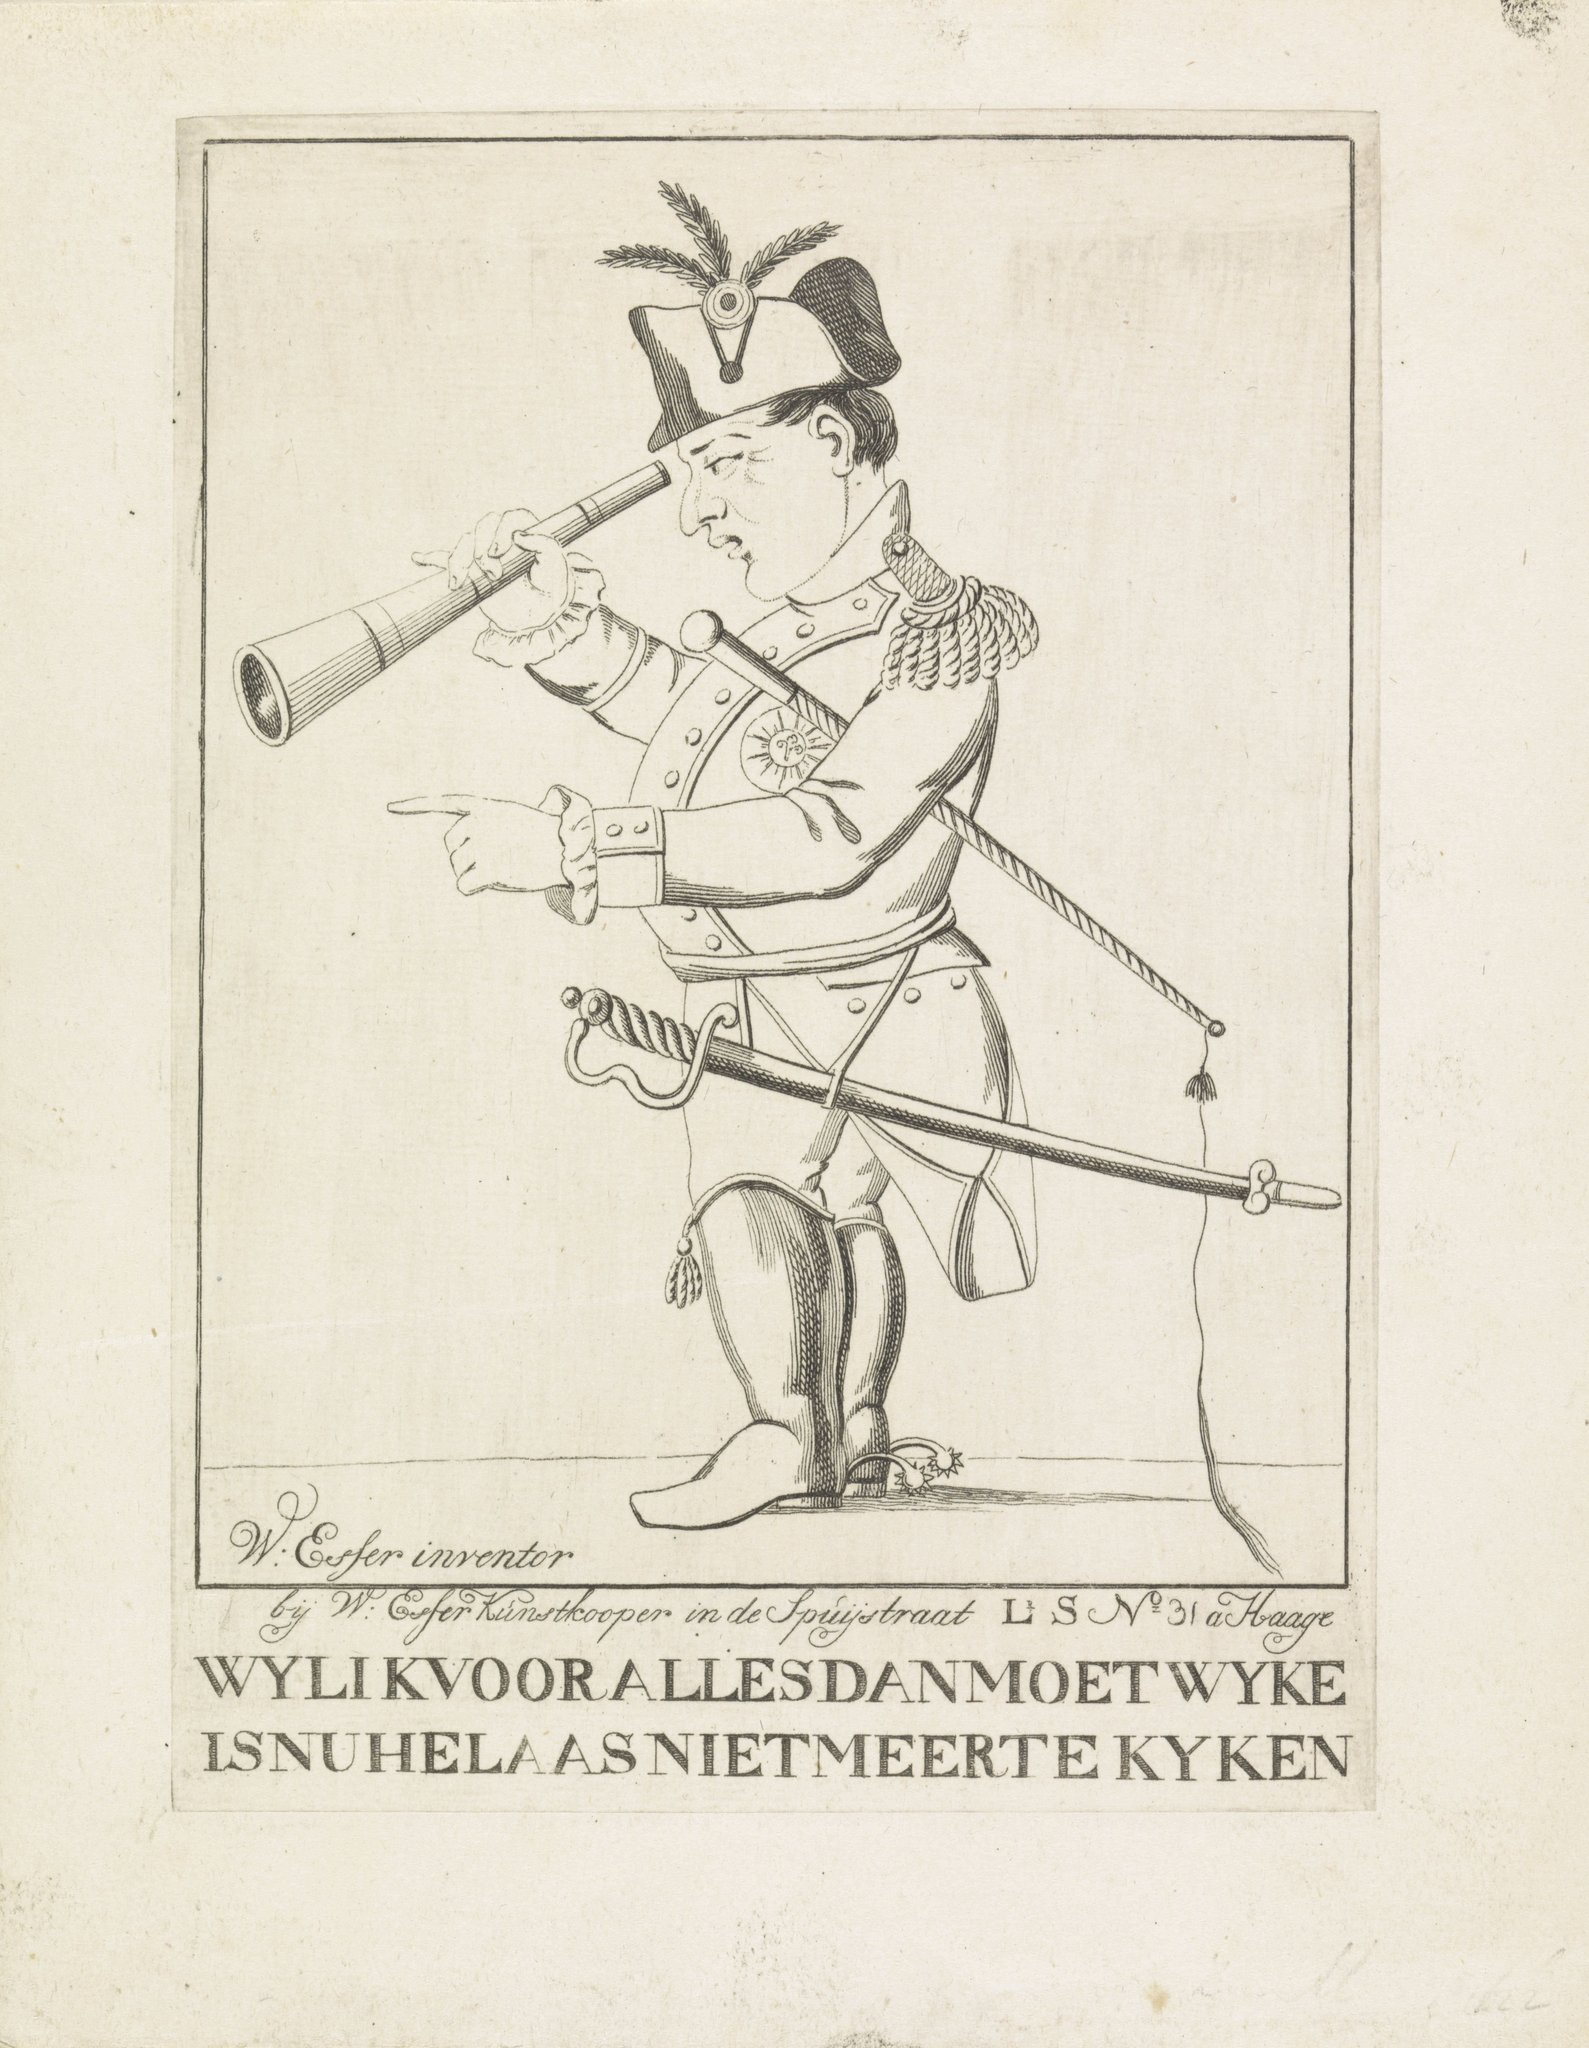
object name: cartoon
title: Wyl ik voor alles dan moet wyke is nu helaas niet meer te kyken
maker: wijnand esser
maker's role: draughtsman, print maker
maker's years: 1779-1860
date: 1814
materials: paper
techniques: engraving, etching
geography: the hague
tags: napoleon i (emperor of the french), telescope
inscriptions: collector's mark: Lugt 2228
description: Spotprent op Napoleons verbanning naar Elba, mei 1814. Napoleon staande in profiel naar links, kijkend door een verrekijker.